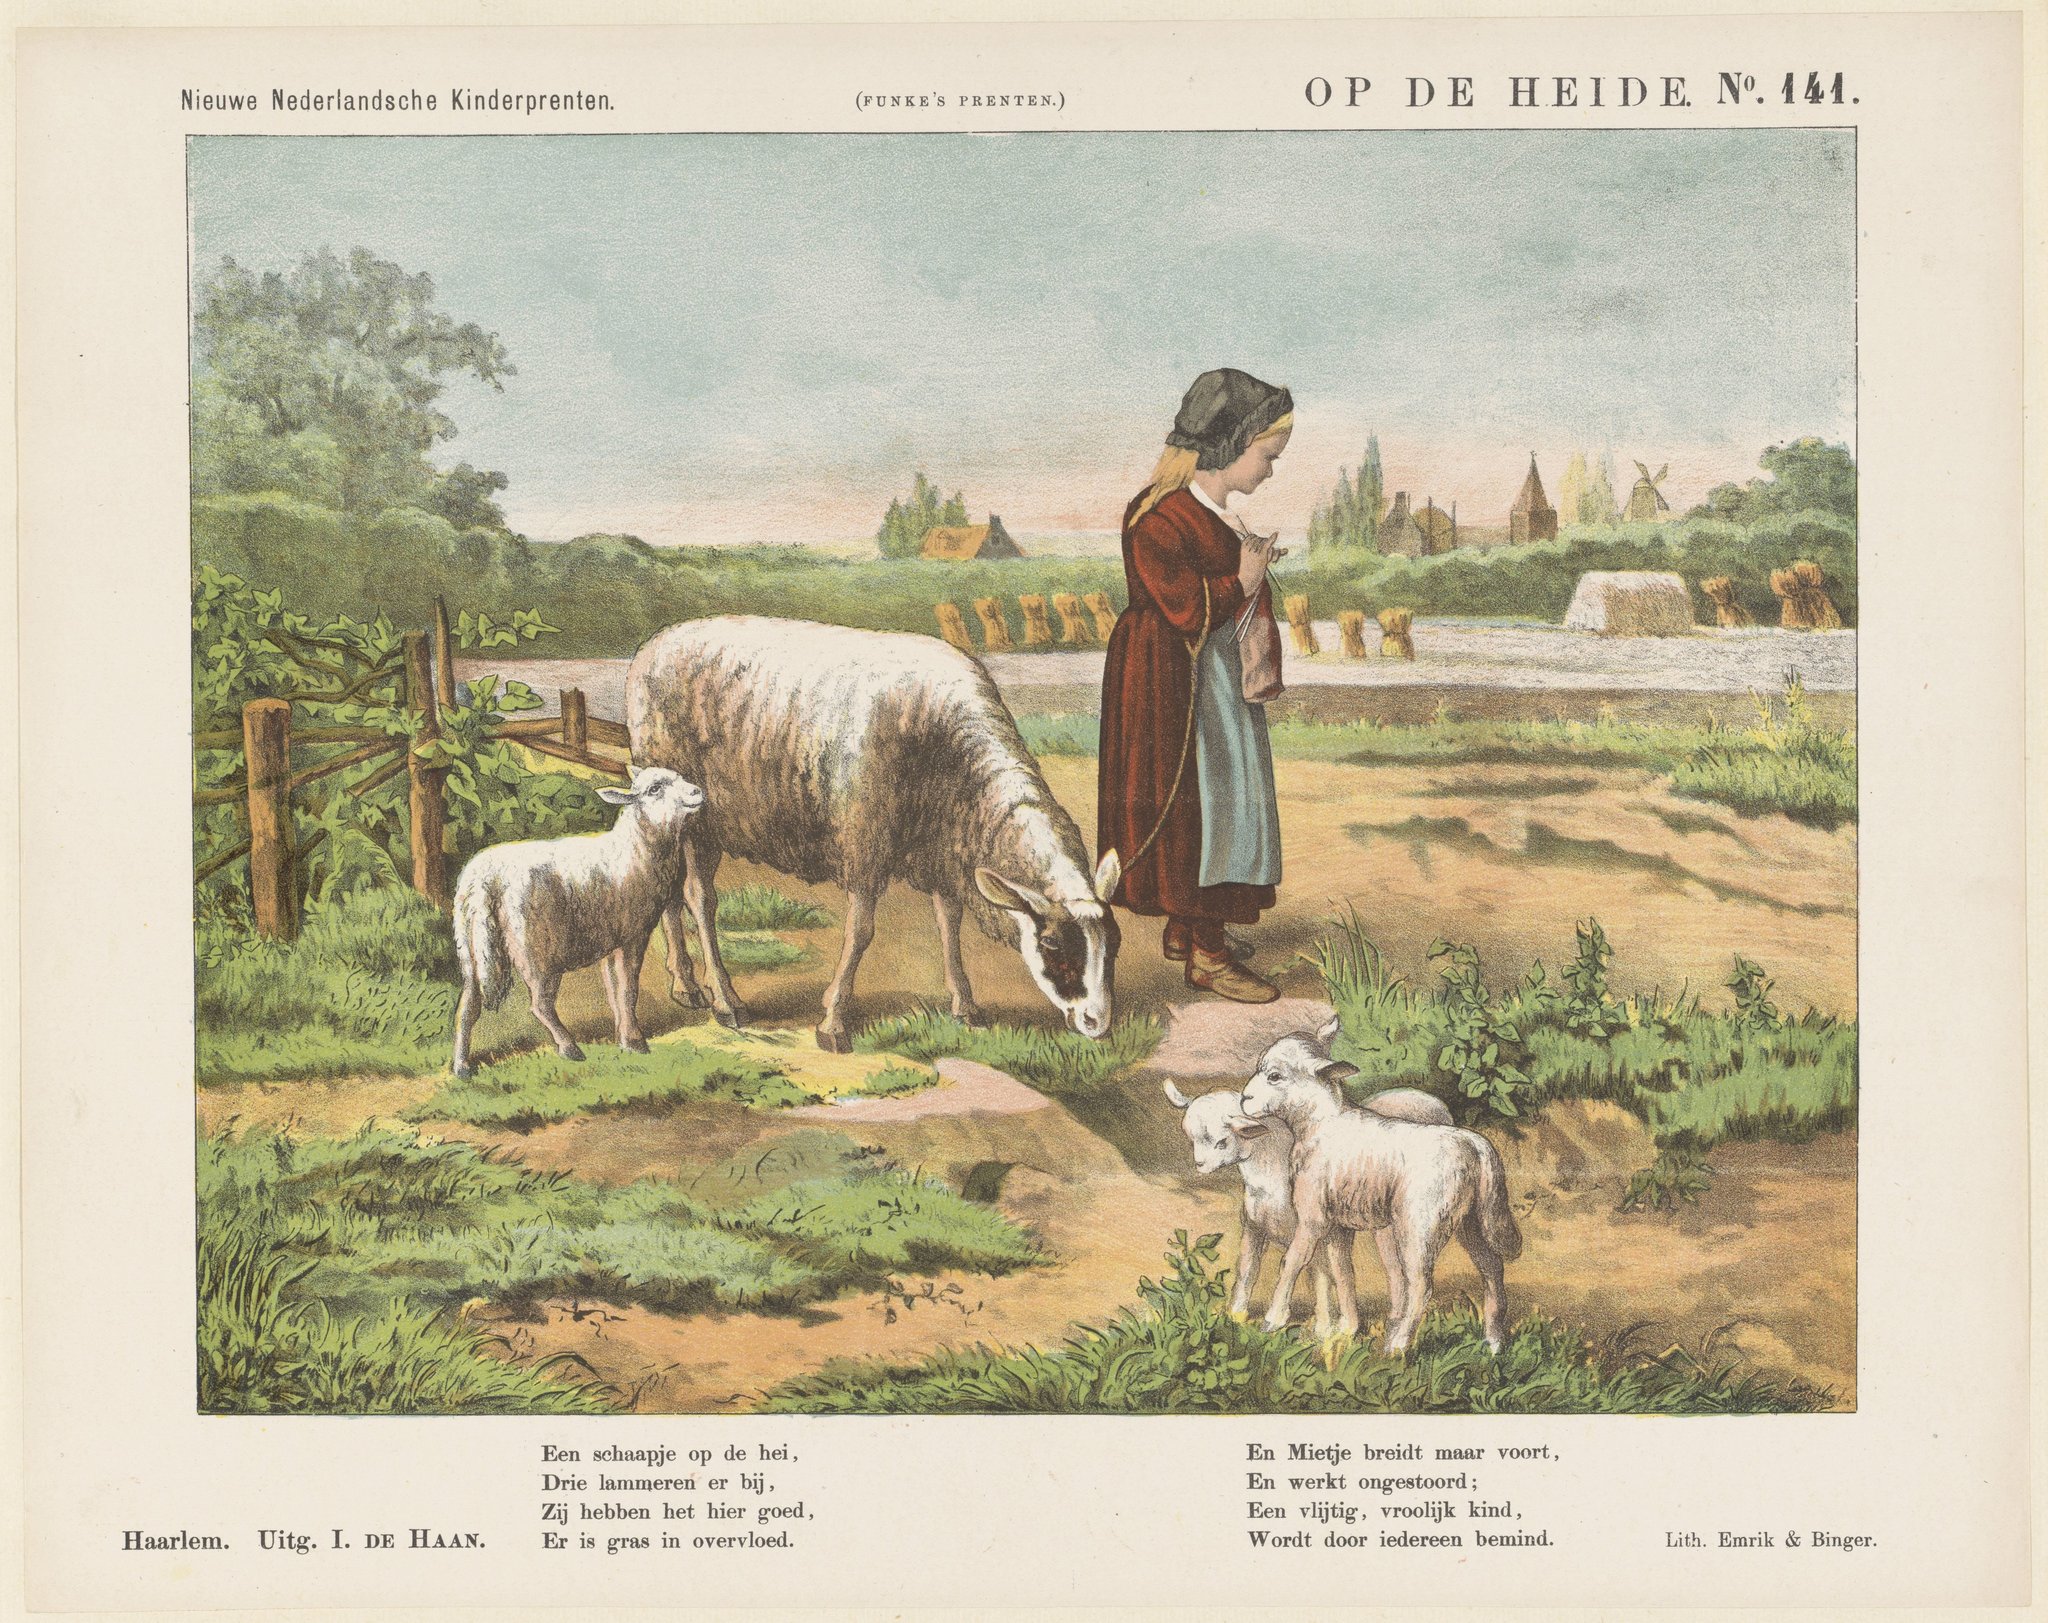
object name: print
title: Nieuwe Nederlandsche kinderprenten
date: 1875-1903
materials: paper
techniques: lithograph, letterpress printing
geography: haarlem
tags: farmers - aa - female farmer, farmer's wife, lamb, ewe, sheep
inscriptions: collector's mark: Lugt 2760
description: Blad met een grote voorstelling van een boerinnetje met een schaap en drie lammetjes in de wei. In de ondermarge een achtregelig vers in twee kolommen. Genummerd rechtsboven: No. 141.